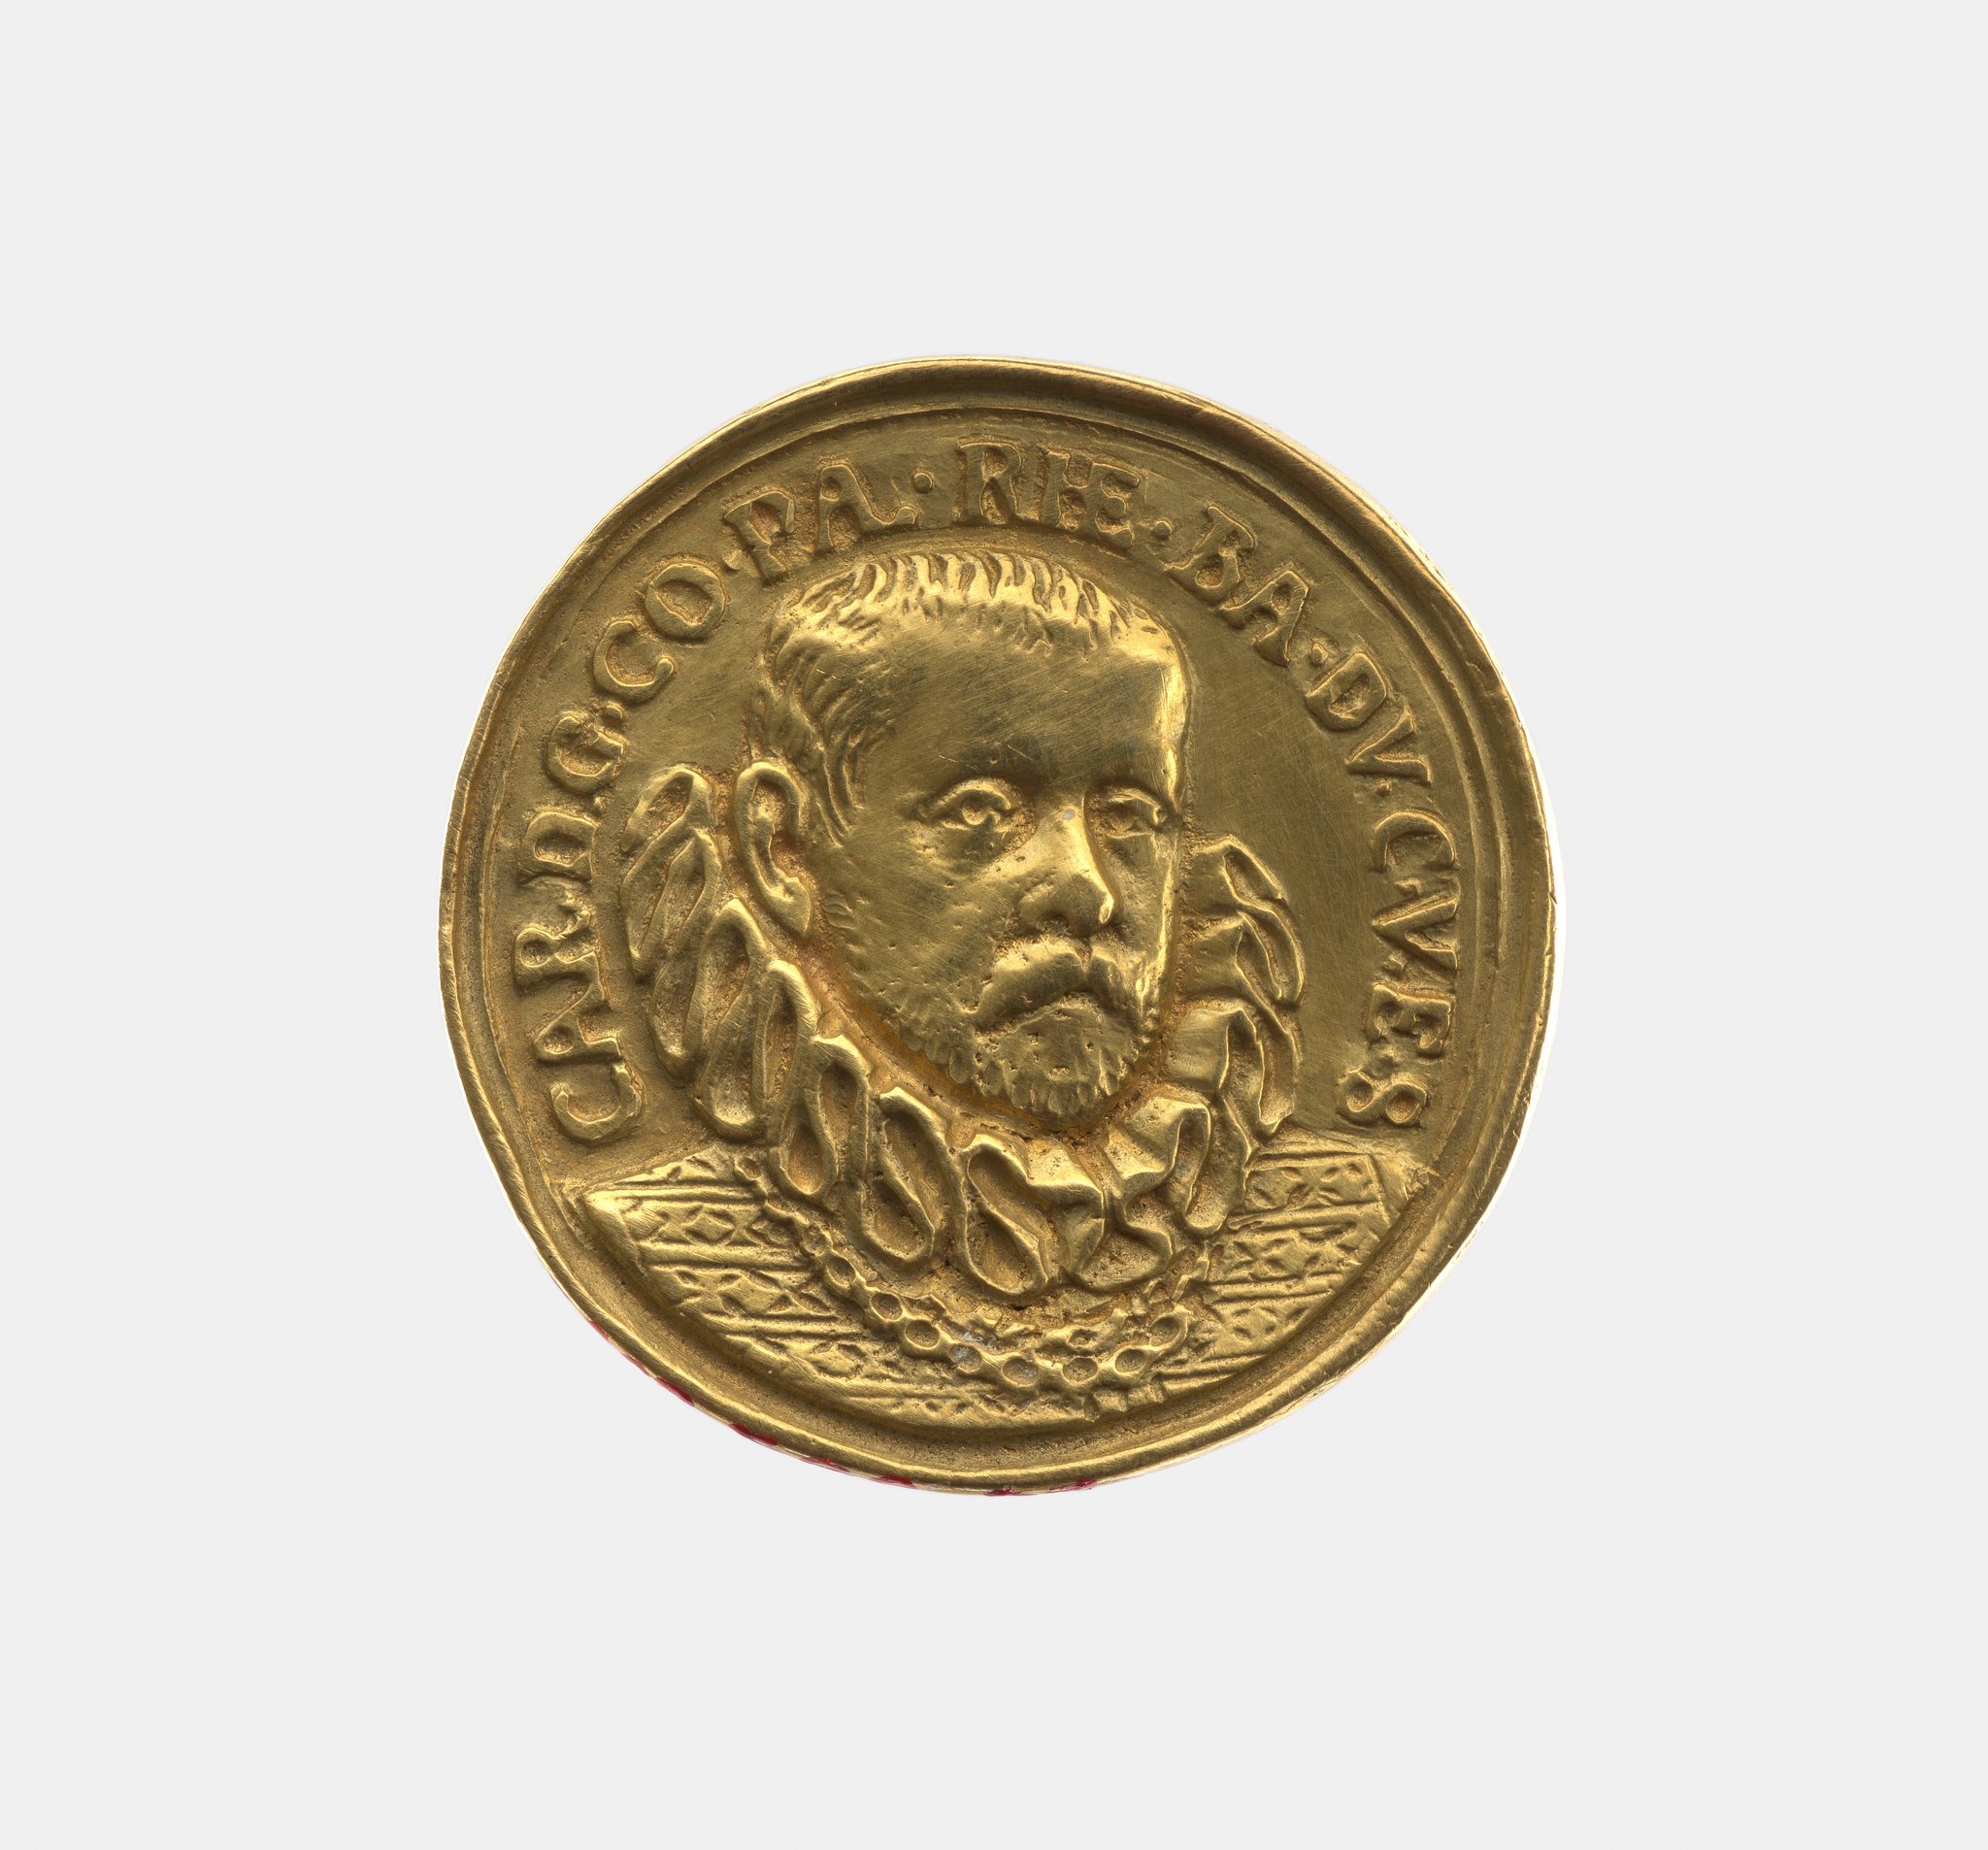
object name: medal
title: Charles I 1560-1600, Count Palatine 1569-1600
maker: balduin drentwett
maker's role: artist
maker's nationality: german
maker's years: 1545-1627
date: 1591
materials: gold